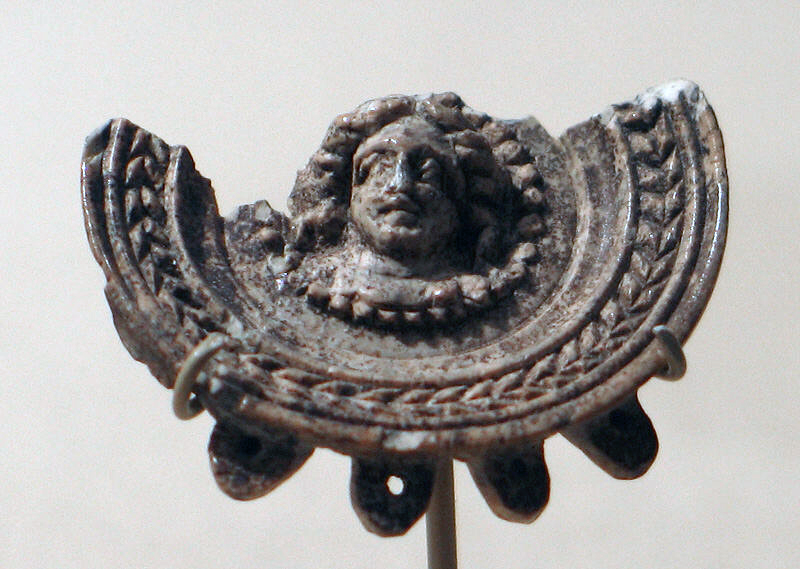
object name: earring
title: Earring(?) with the Head of a Male Figure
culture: gandhara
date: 301-400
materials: ivory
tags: gandhara,heads